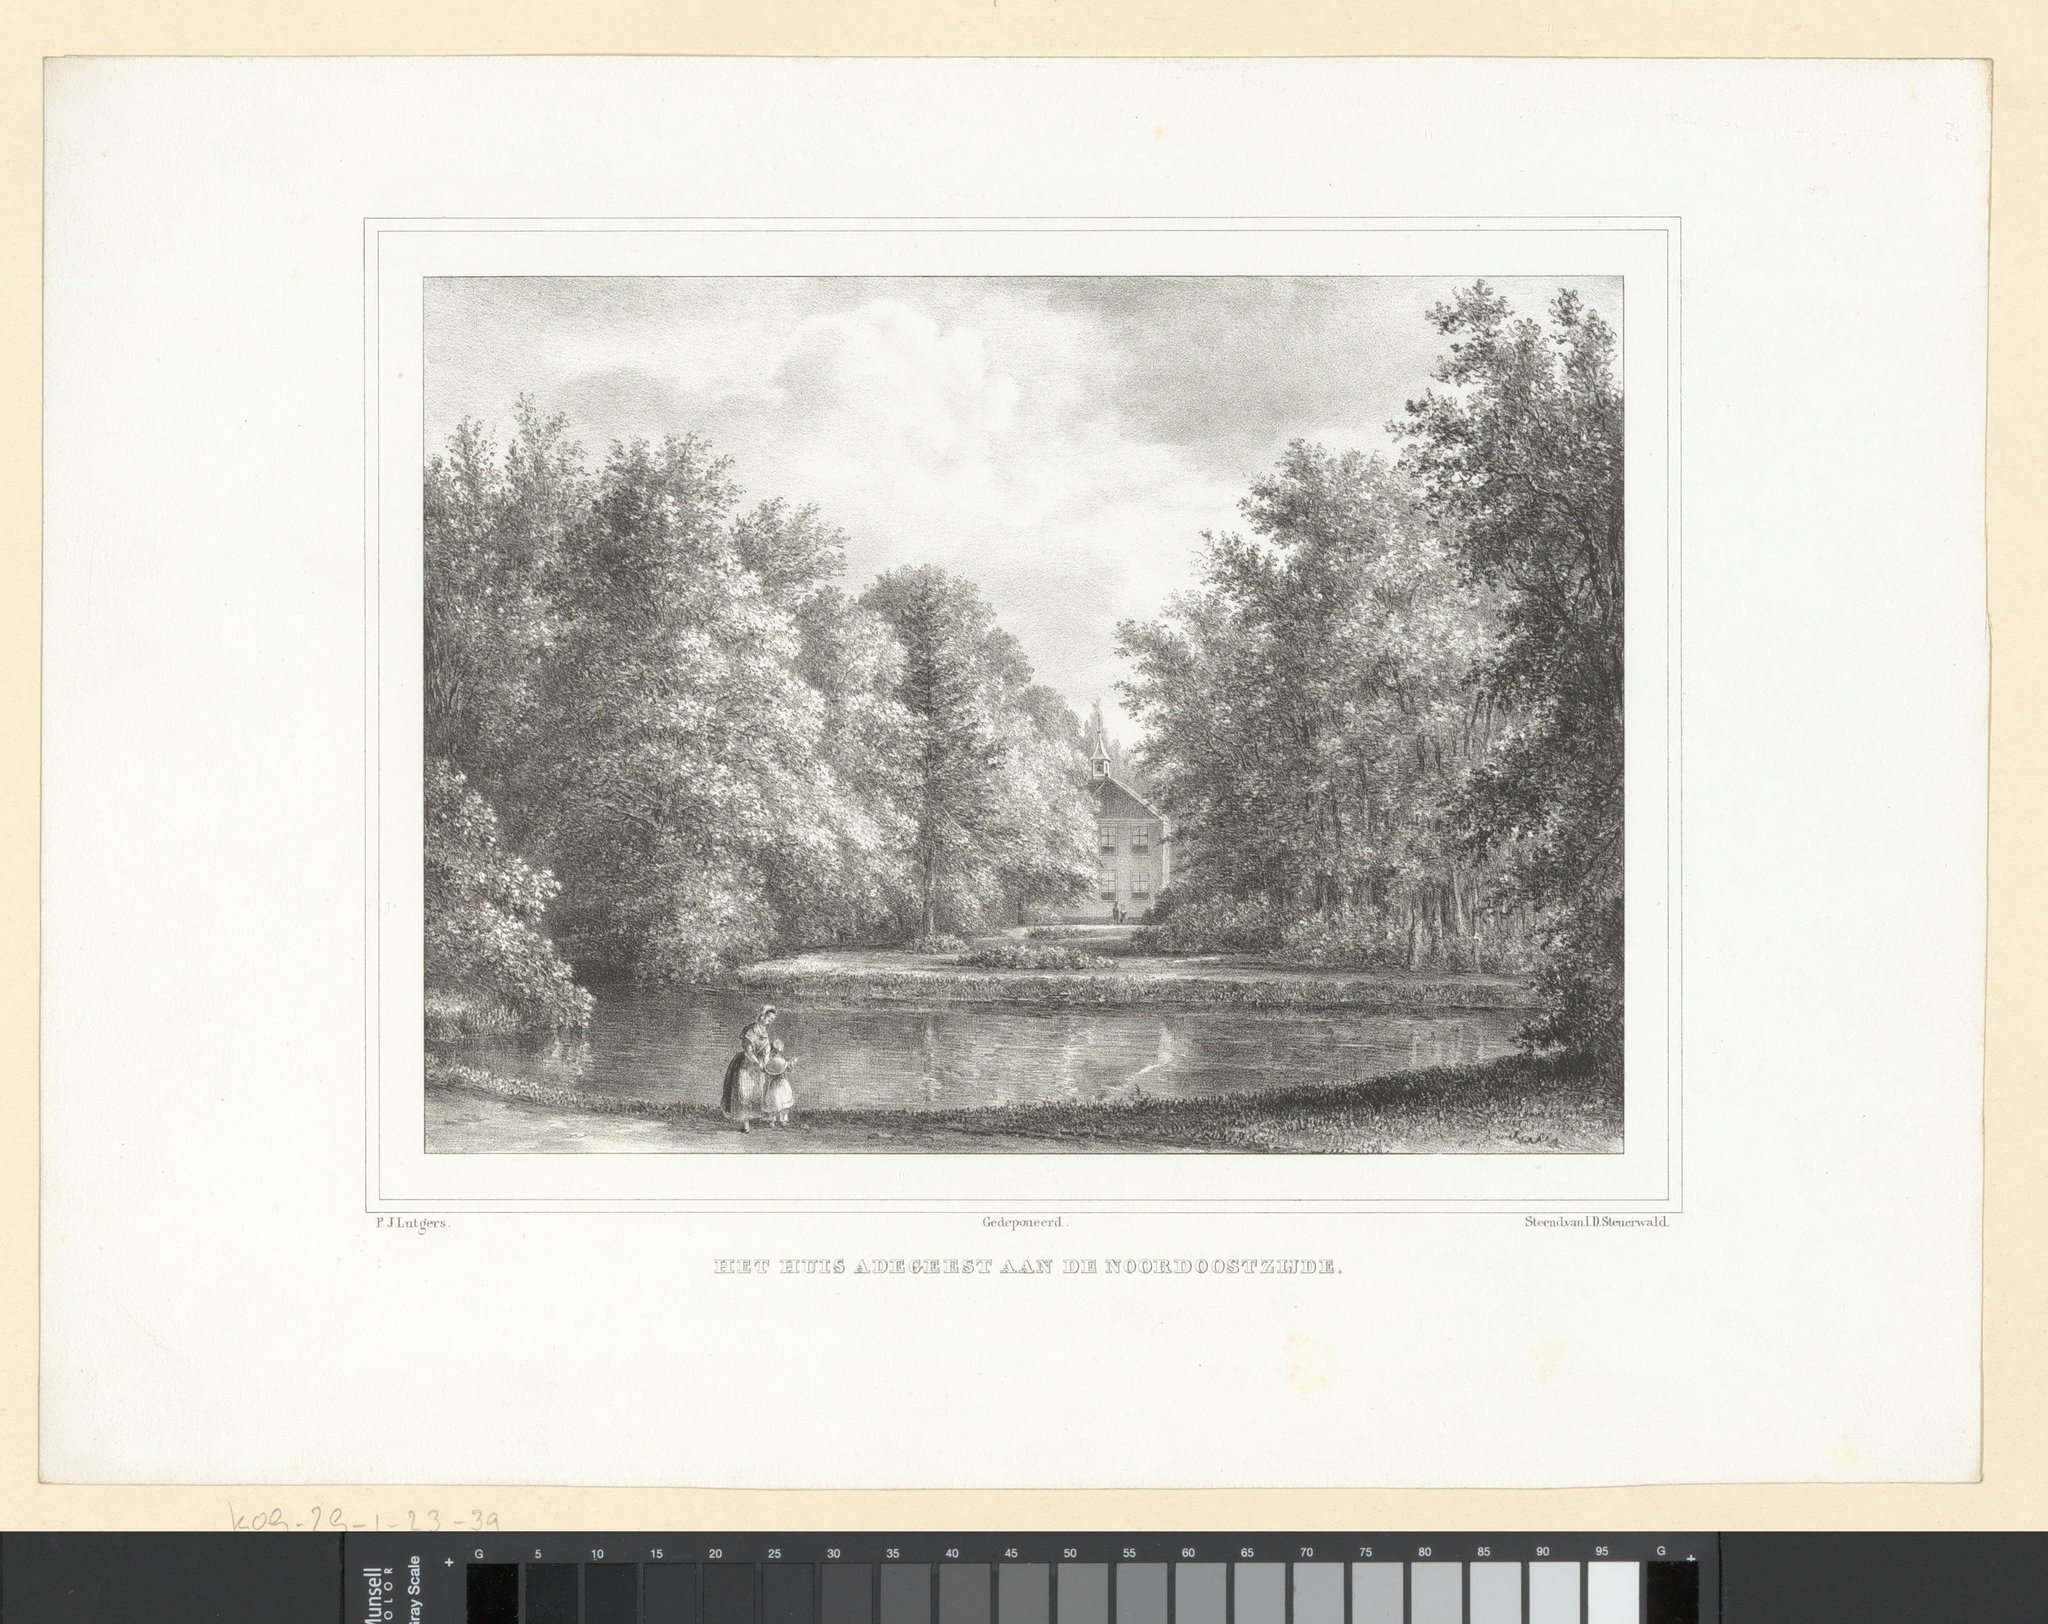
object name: print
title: Gezicht op buitenplaats Adegeest te Voorschoten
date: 1855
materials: paper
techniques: lithograph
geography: the hague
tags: trees, farm or solitary house in landscape, voorschoten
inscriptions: : ‘Gedeponeerd’, collector's mark: Lugt 1641, stamp, stamp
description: Onderwerpsrubrieken binnen de Atlas Zeden en Gewoonten: Zeden en Gewoonten in Engeren Zin, De Woning. Kastelen en buitenplaatsen. Holland.